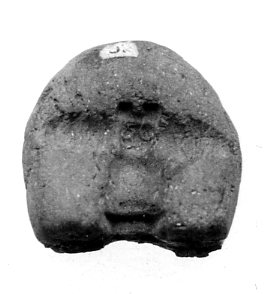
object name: mold, cat amulet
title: Mold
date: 1550-1295 BCE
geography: egypt